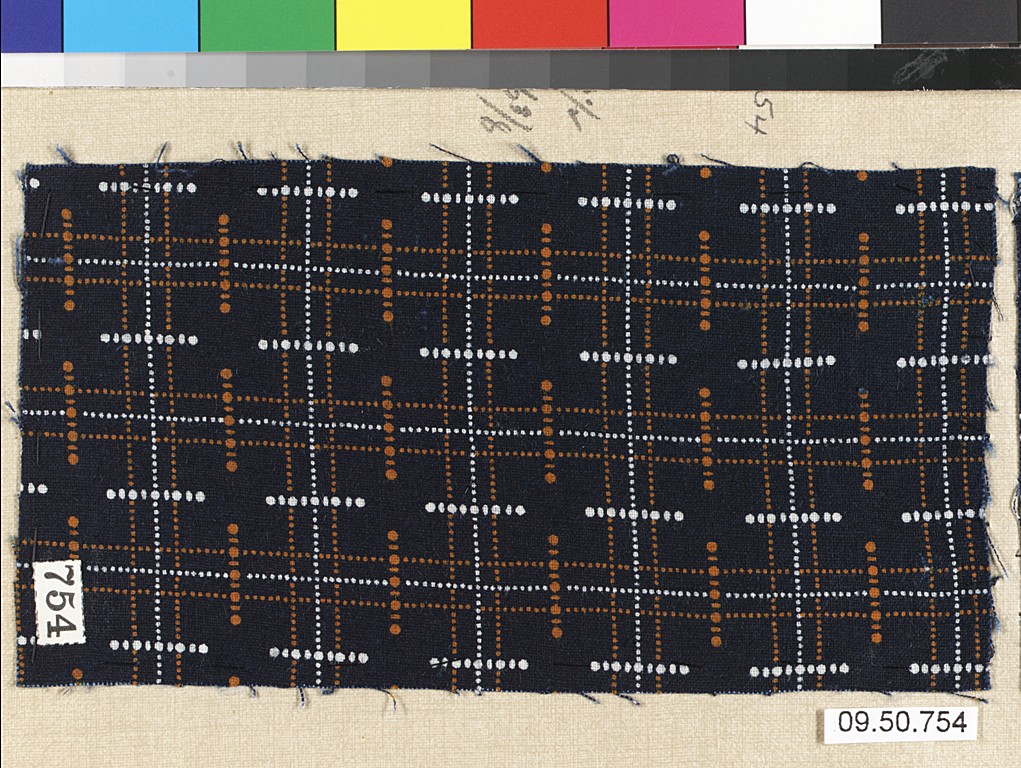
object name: piece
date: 1801-1900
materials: cotton